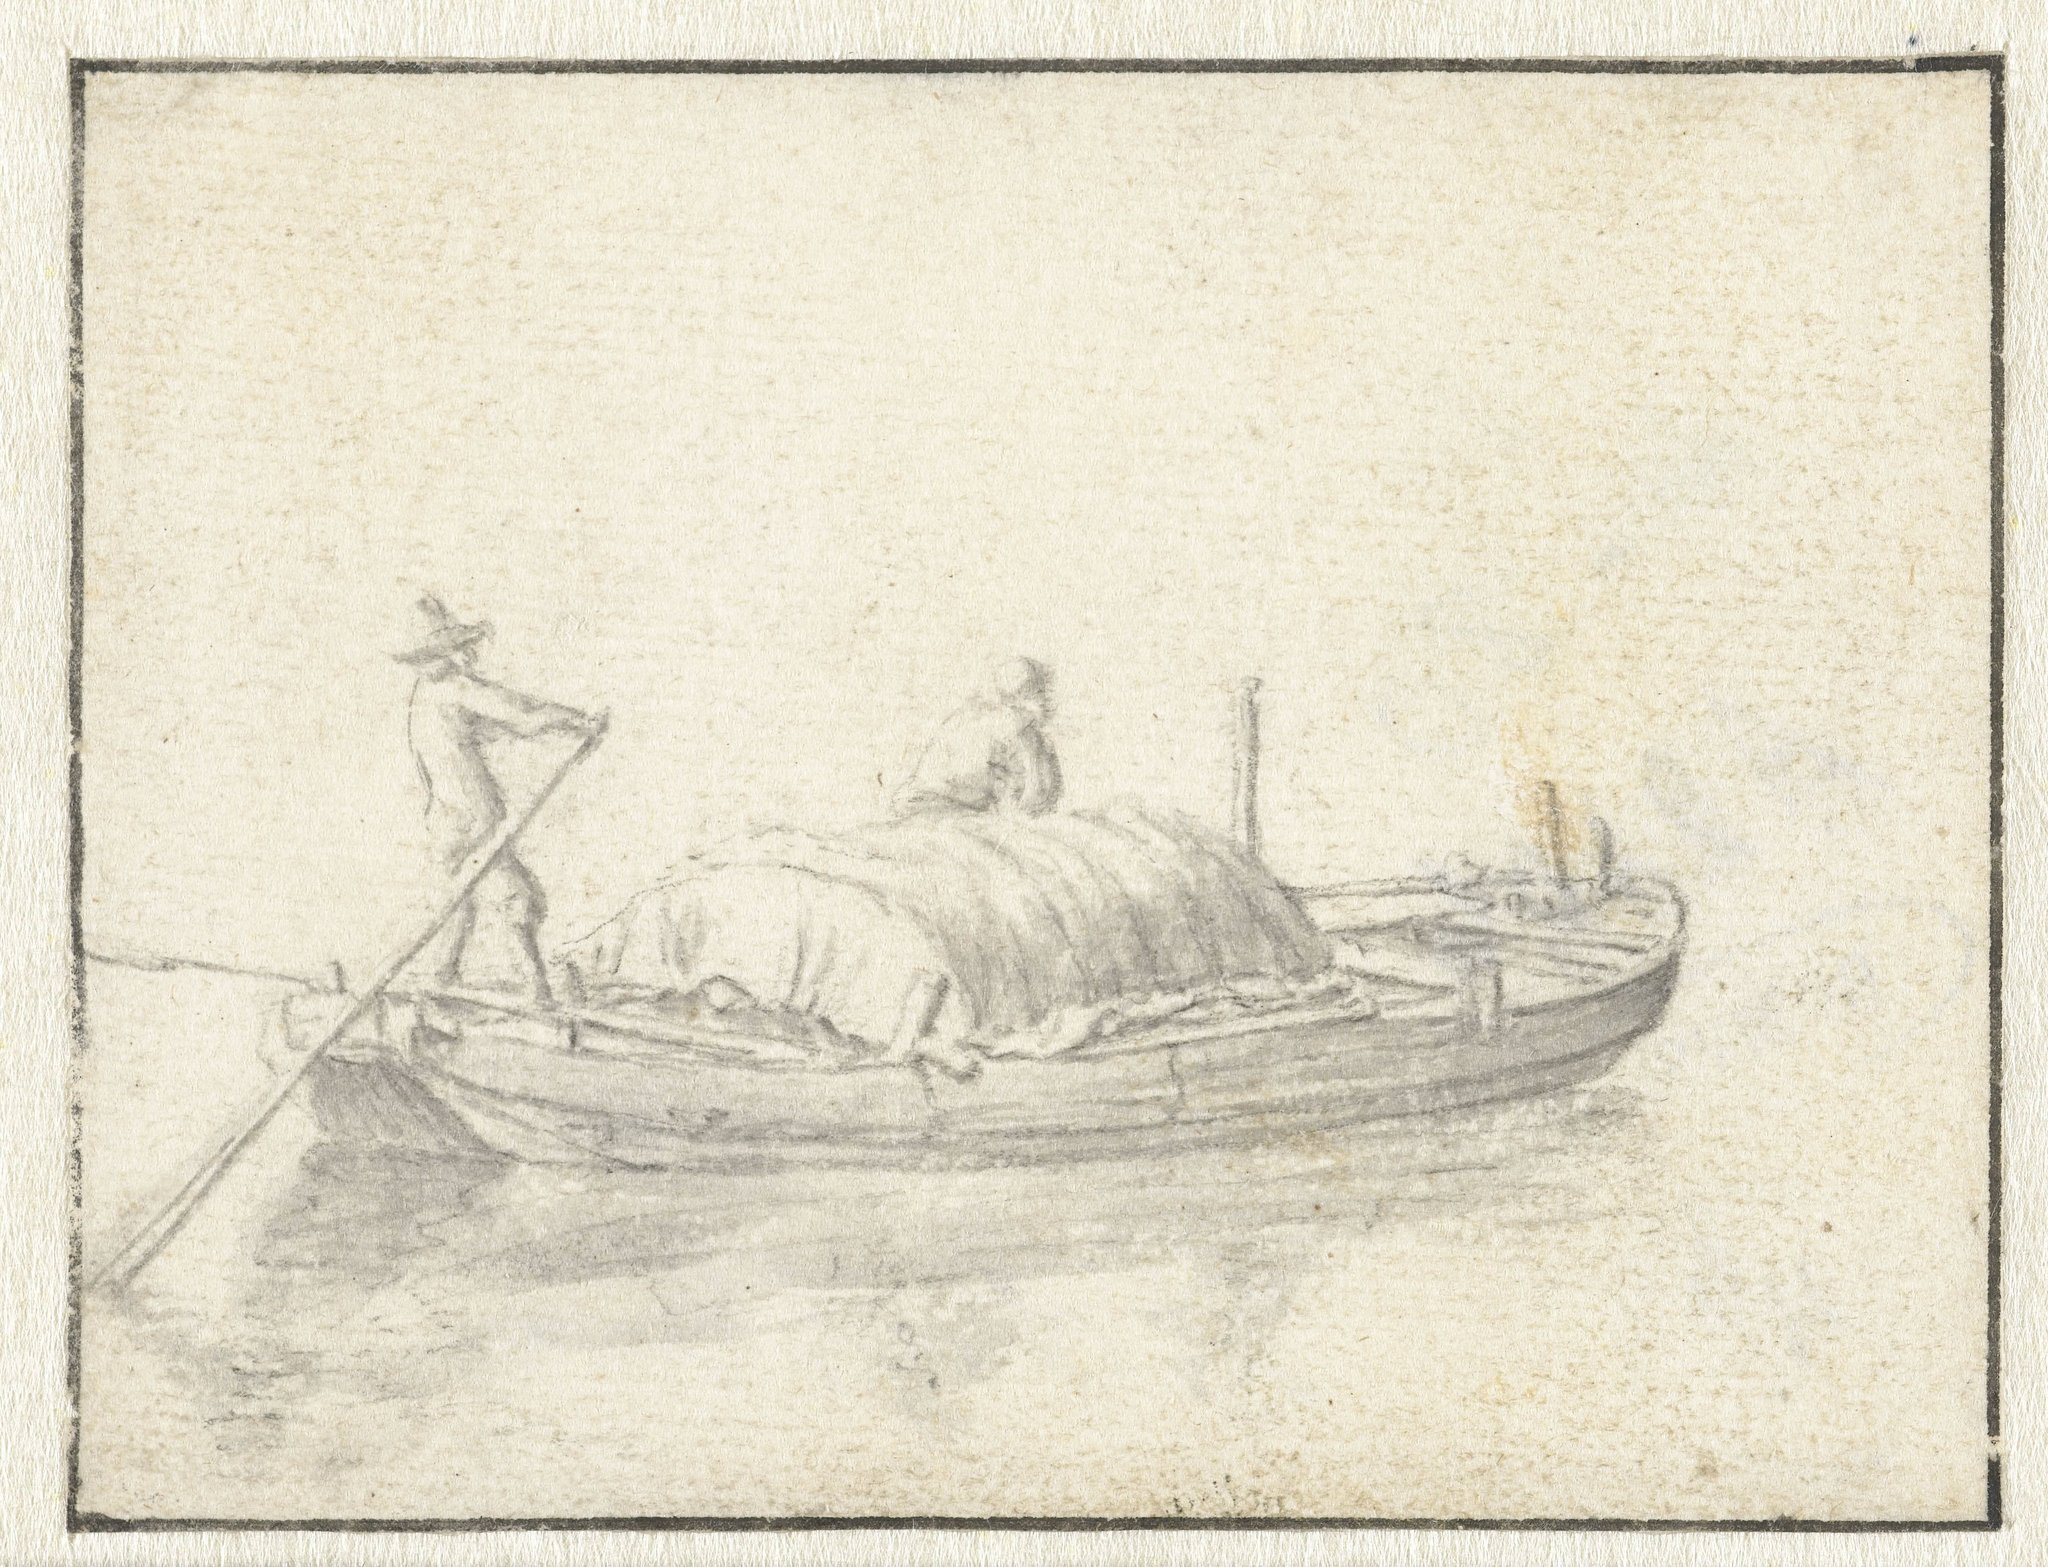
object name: drawing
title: Deels overdekte schuit met twee mannen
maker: herman saftleven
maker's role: draughtsman, painter, print maker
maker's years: 1609-1685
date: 1619-1685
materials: chalk, paper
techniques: brush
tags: oaring, sculling